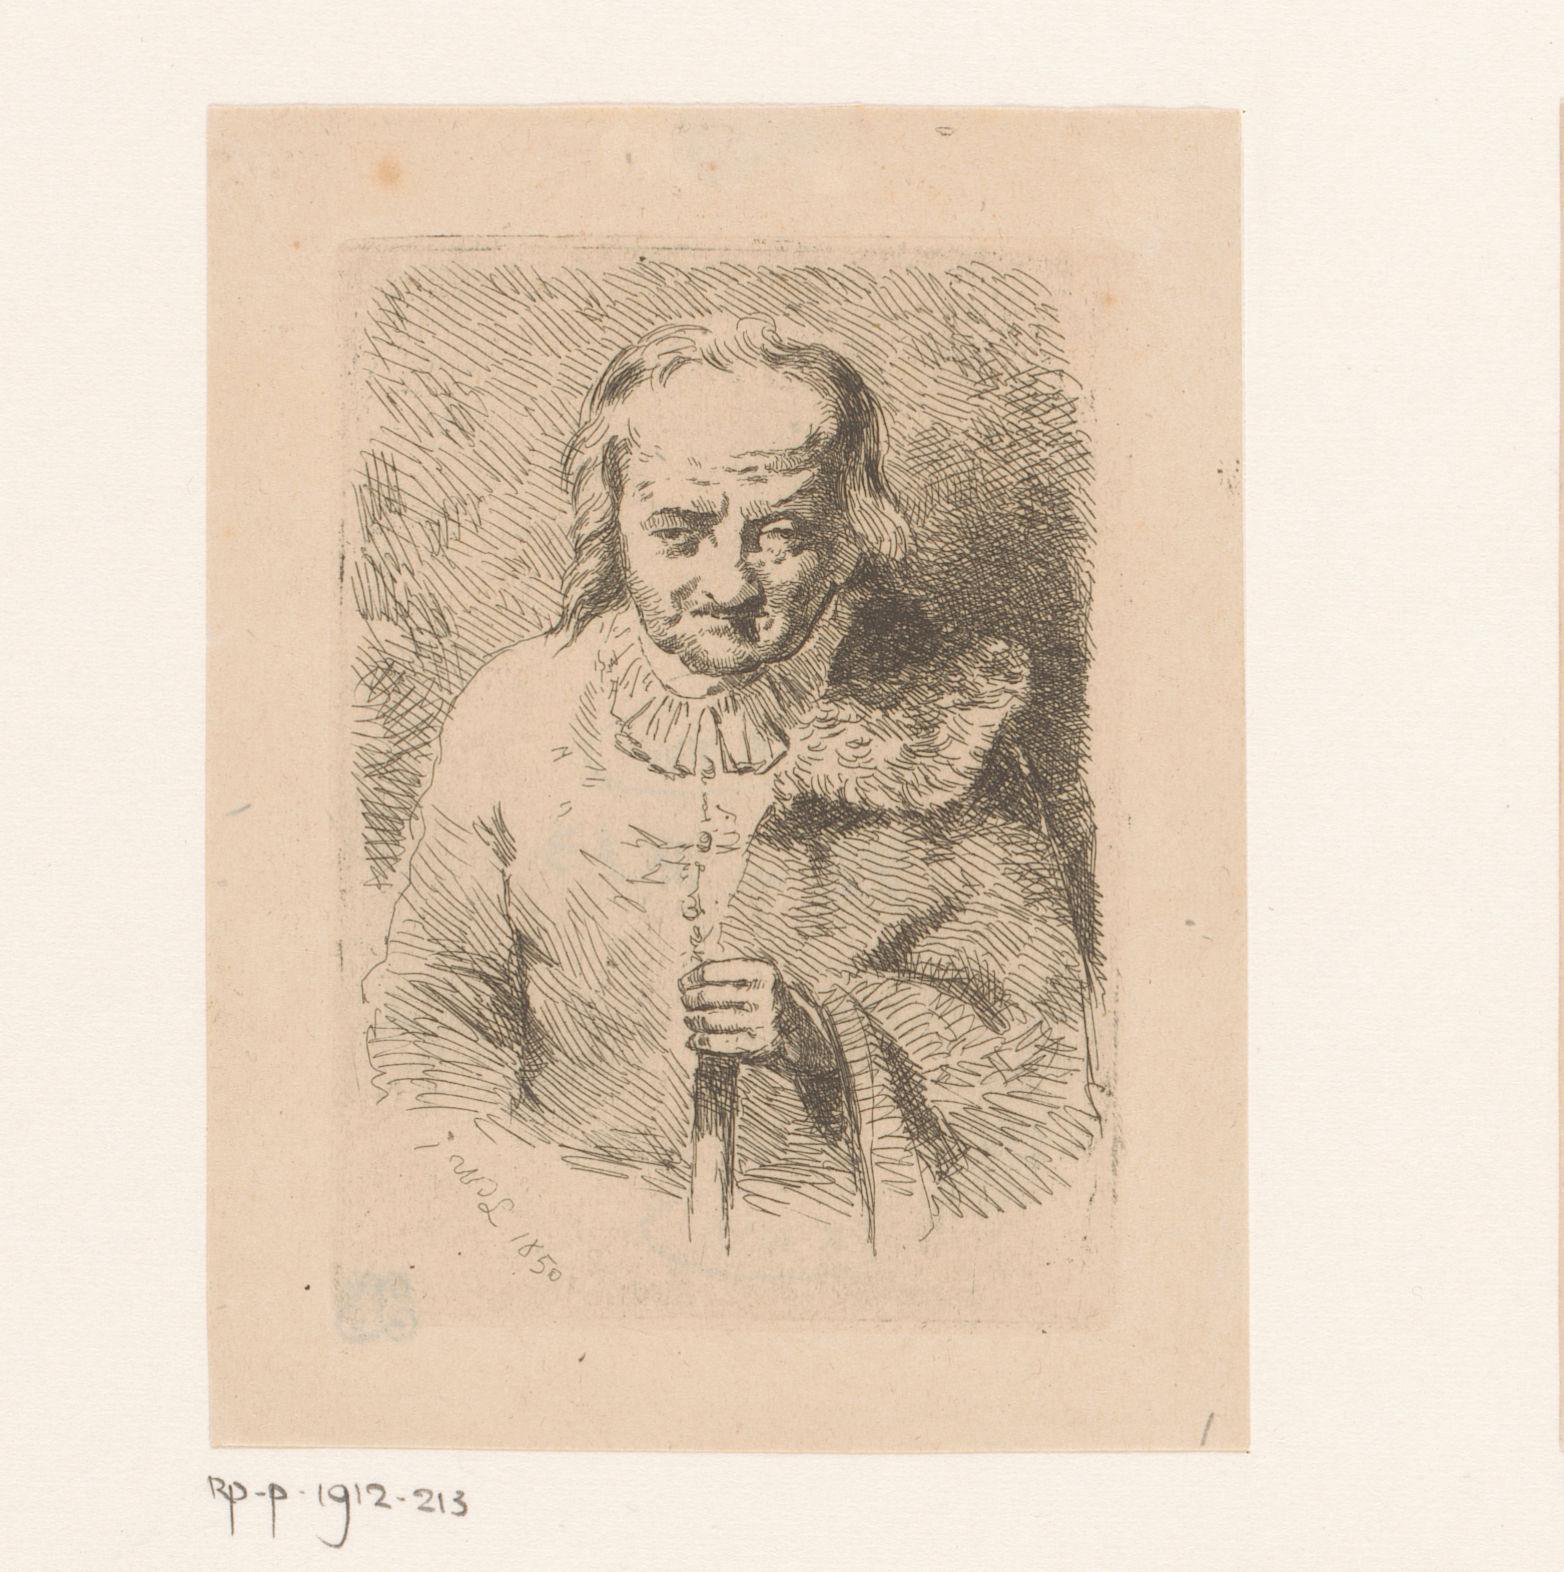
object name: print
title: Oude man met een stok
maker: willem linnig (i)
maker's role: print maker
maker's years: 1819-1885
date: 1850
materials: paper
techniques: etching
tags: walking-stick, staff, old man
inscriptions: collector's mark: Lugt 1485, collector's mark: Lugt 2228